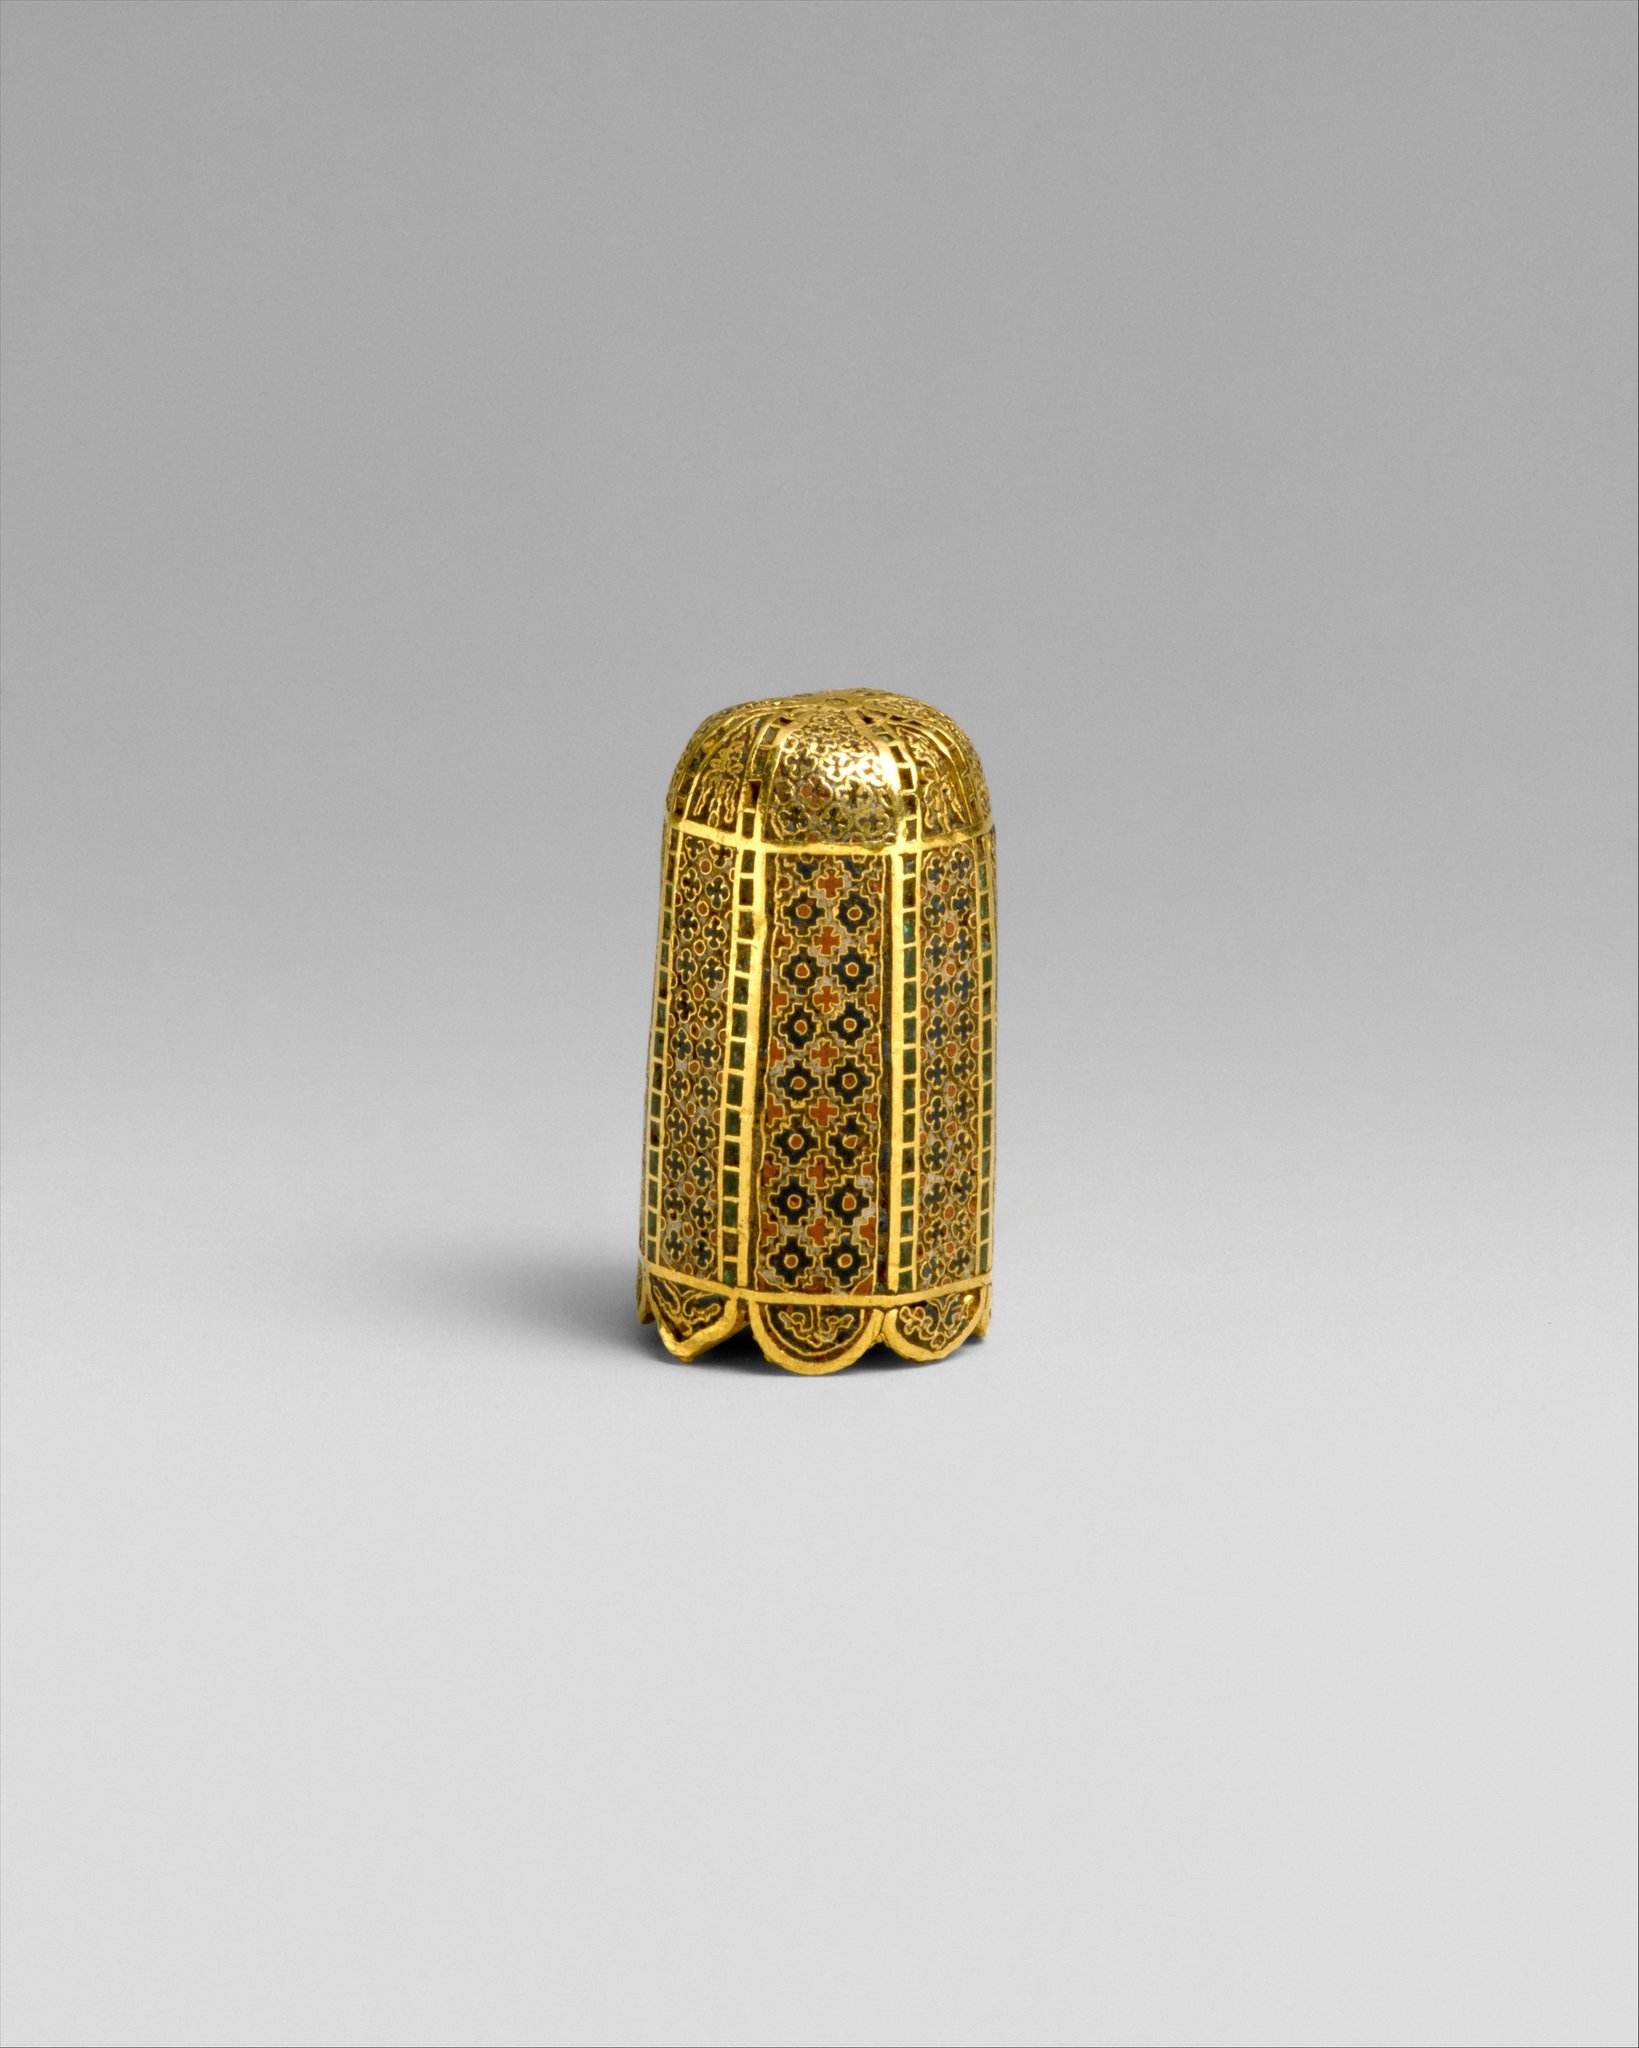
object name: pointer tip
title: Tip of a Pointer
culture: byzantine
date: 1080-1150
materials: enamel, gold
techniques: enamel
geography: constantinople